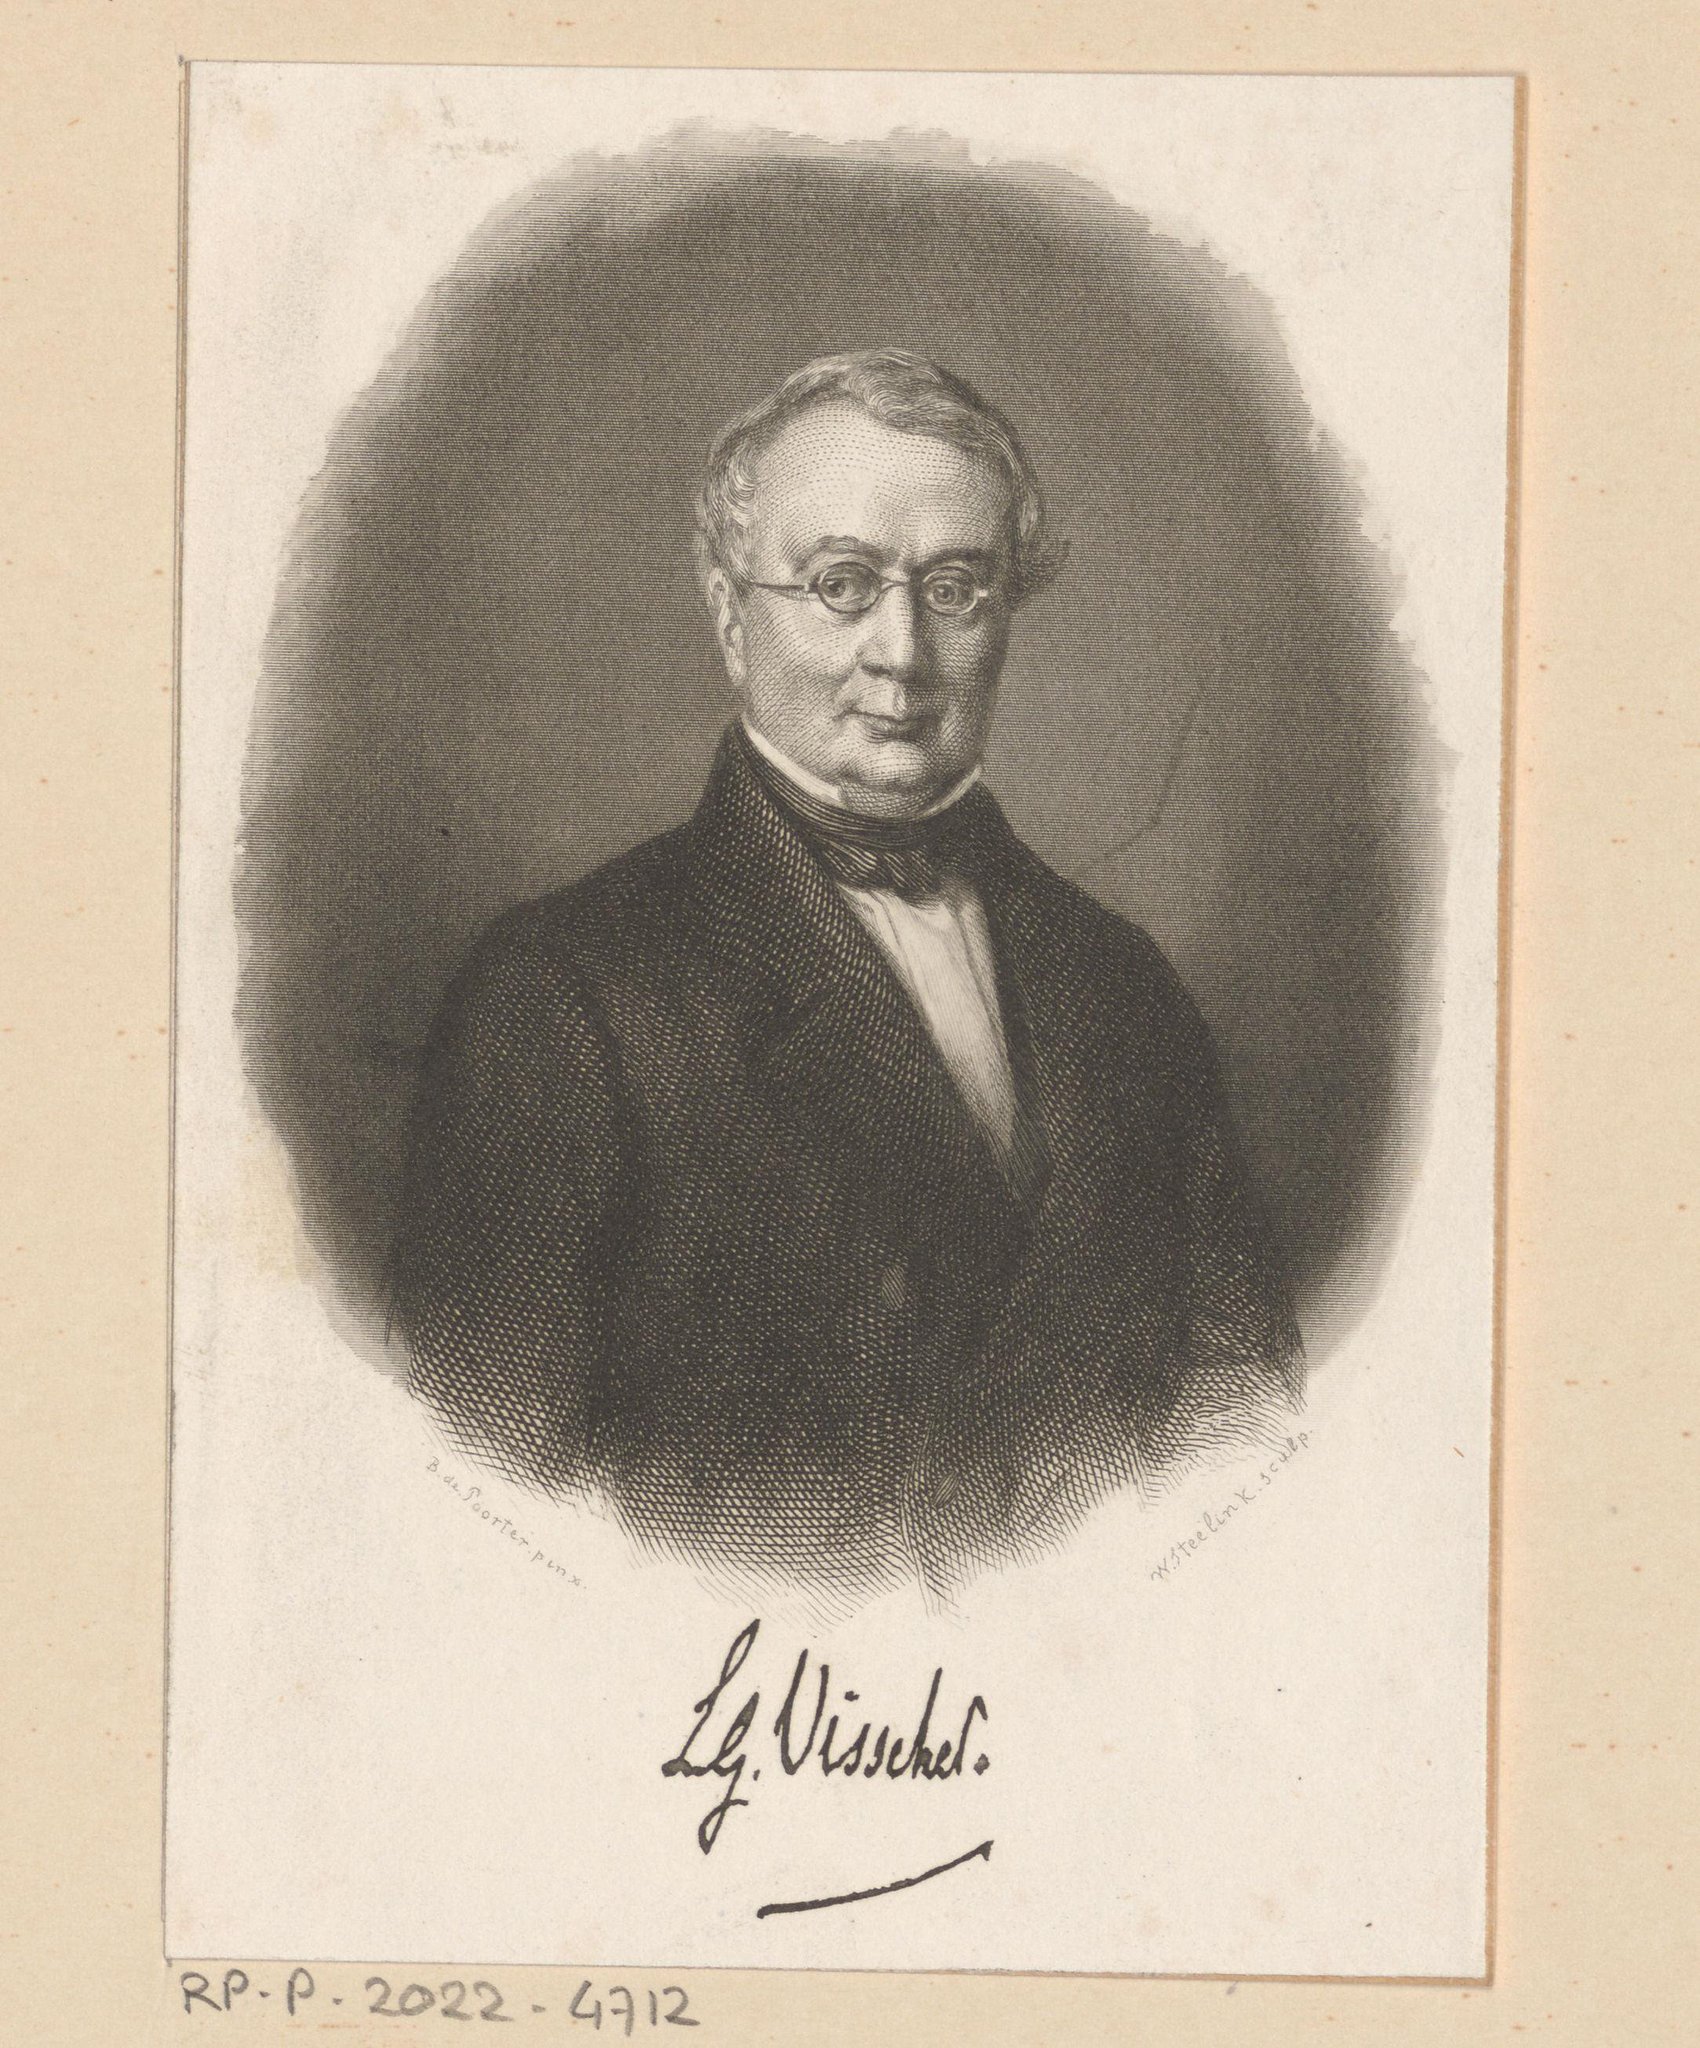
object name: print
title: Portret van Lodewijk Gerard Visscher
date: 1857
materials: paper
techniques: engraving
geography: amsterdam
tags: scholar, philosopher, historical persons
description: Prent uit: Utrechtsche Studenten-Almanak (1857).